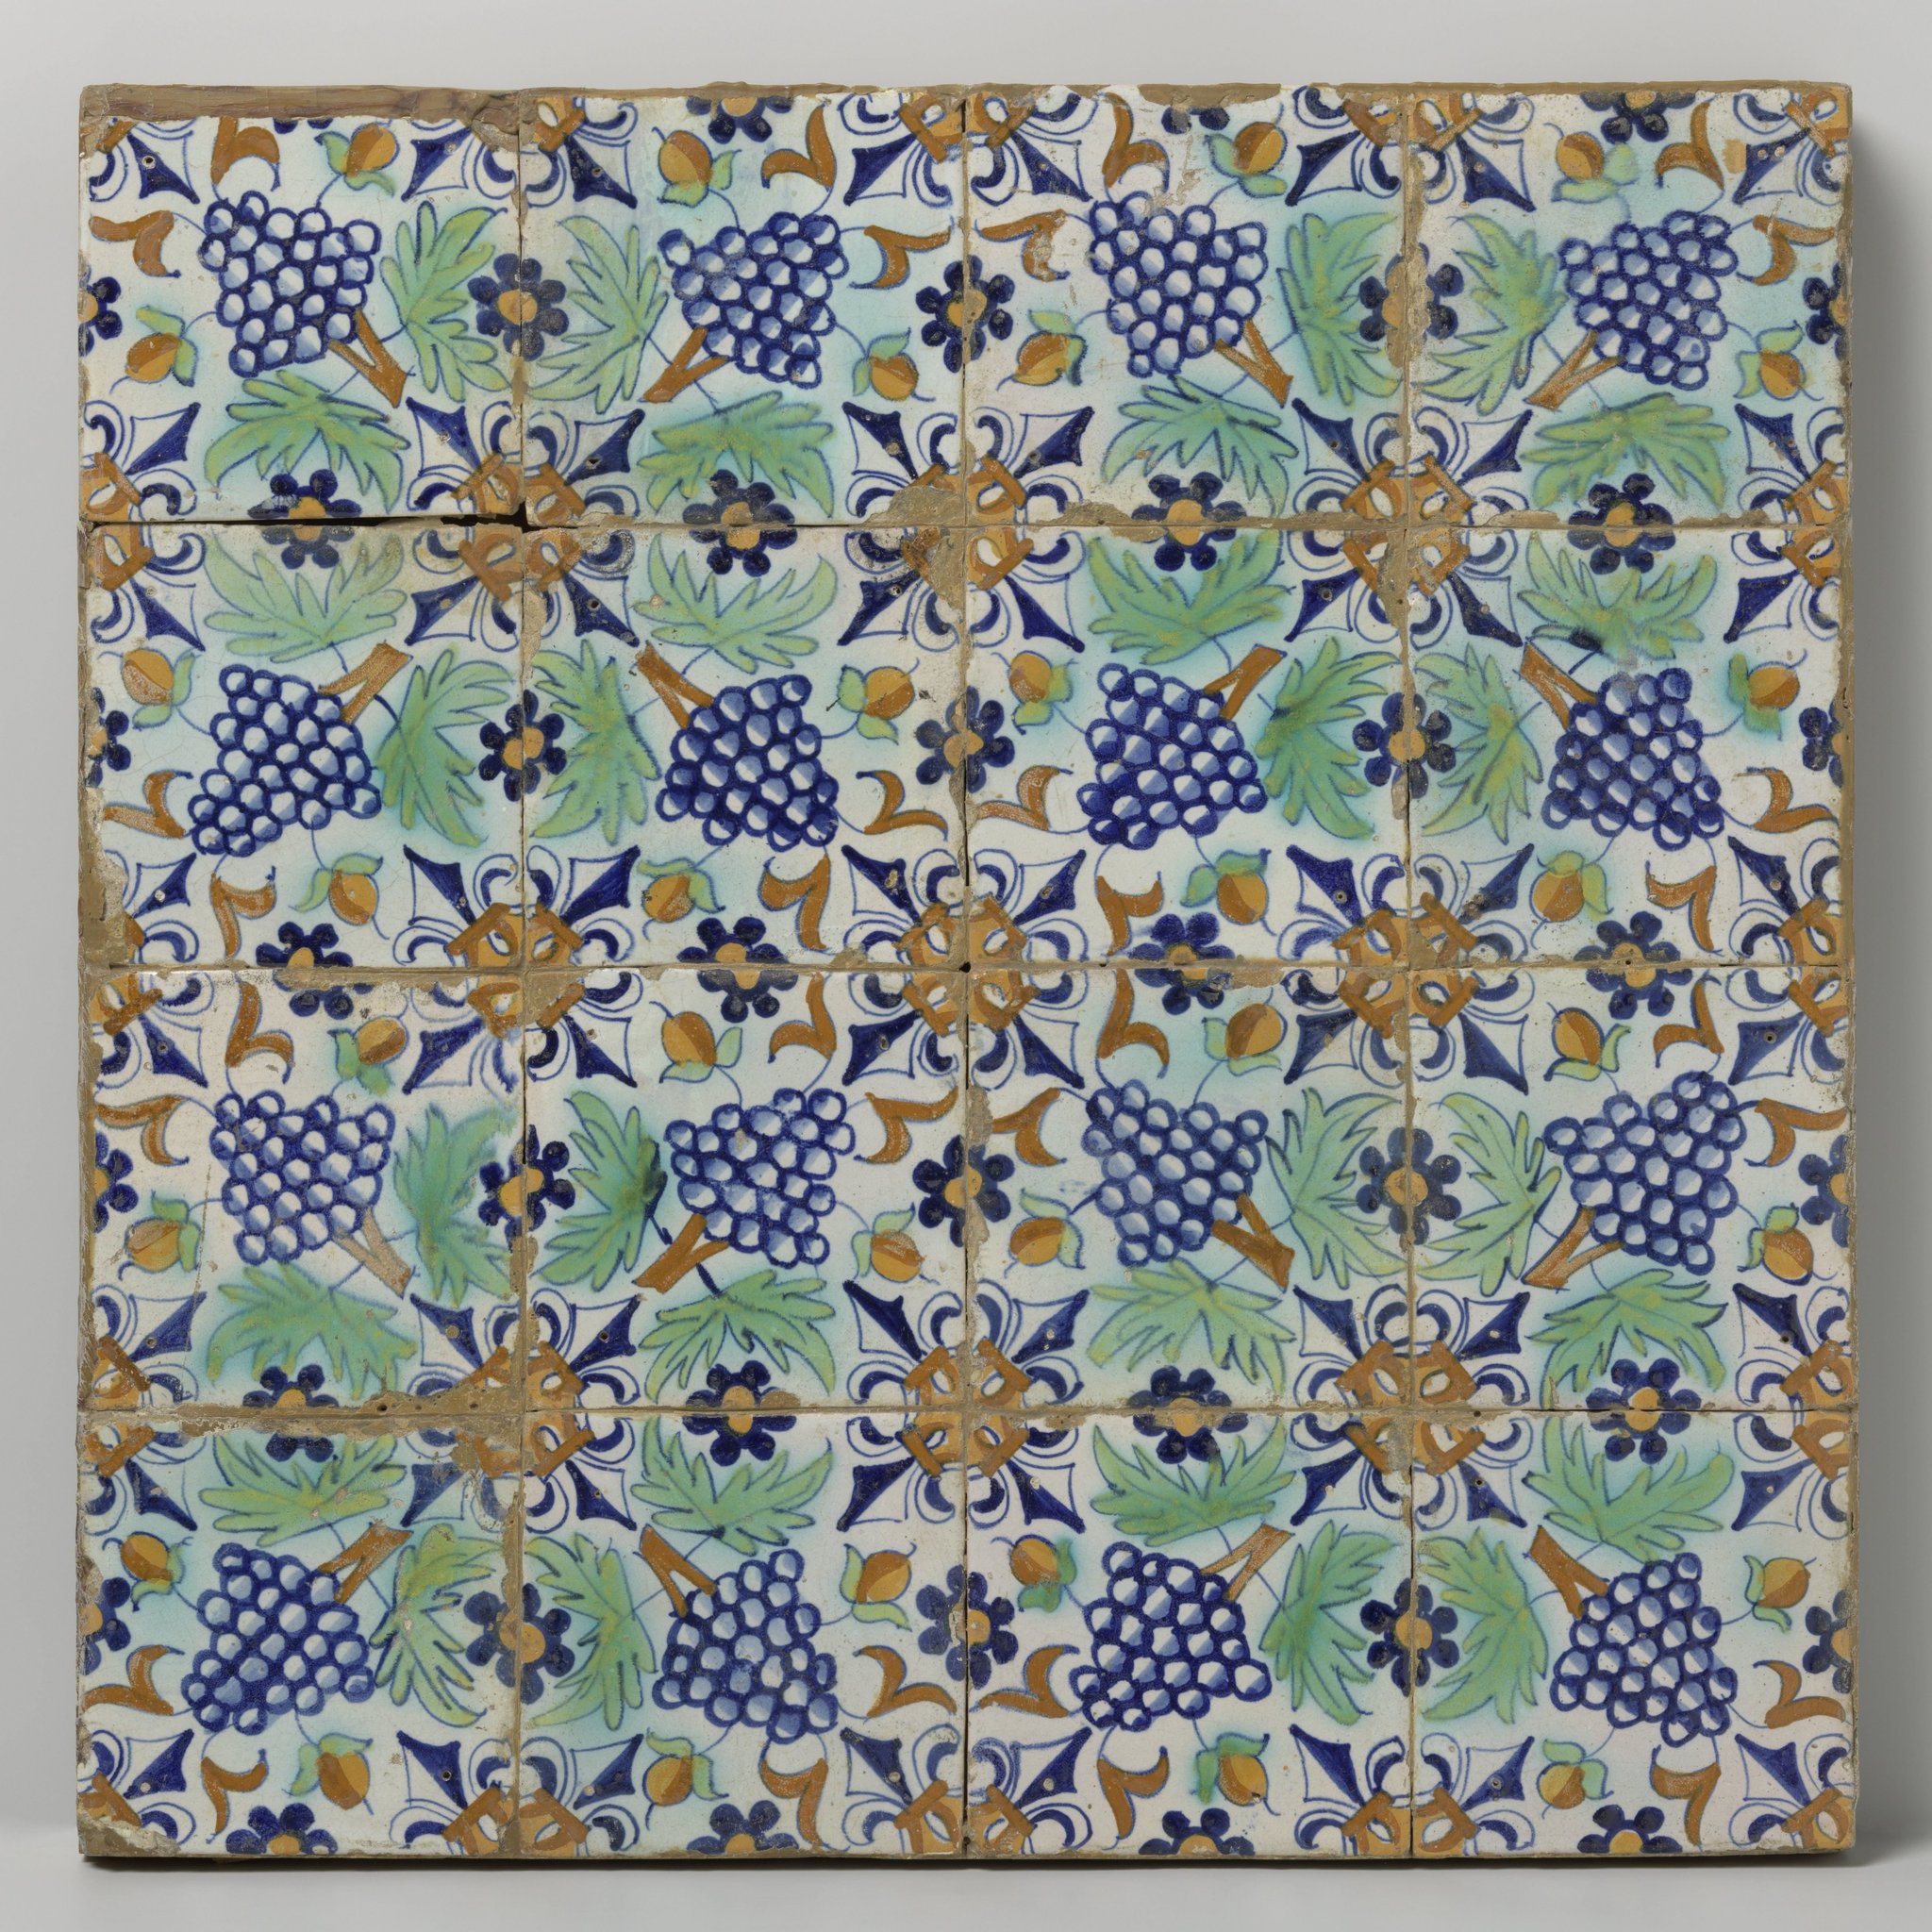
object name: tegelveld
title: Veld van zestien tegels met druiventrossen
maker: Anonymous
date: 1600-1625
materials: earthenware, glaze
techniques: maiolica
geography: netherlands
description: Veld van zestien tegels (4 x 4) elk met een veelkleurig (blauw, groen, oranje en geel) geschilderde druiventros, diagonaal geplaatst. Langs de randen, een halve rozet en in de hoeken, een lelie.